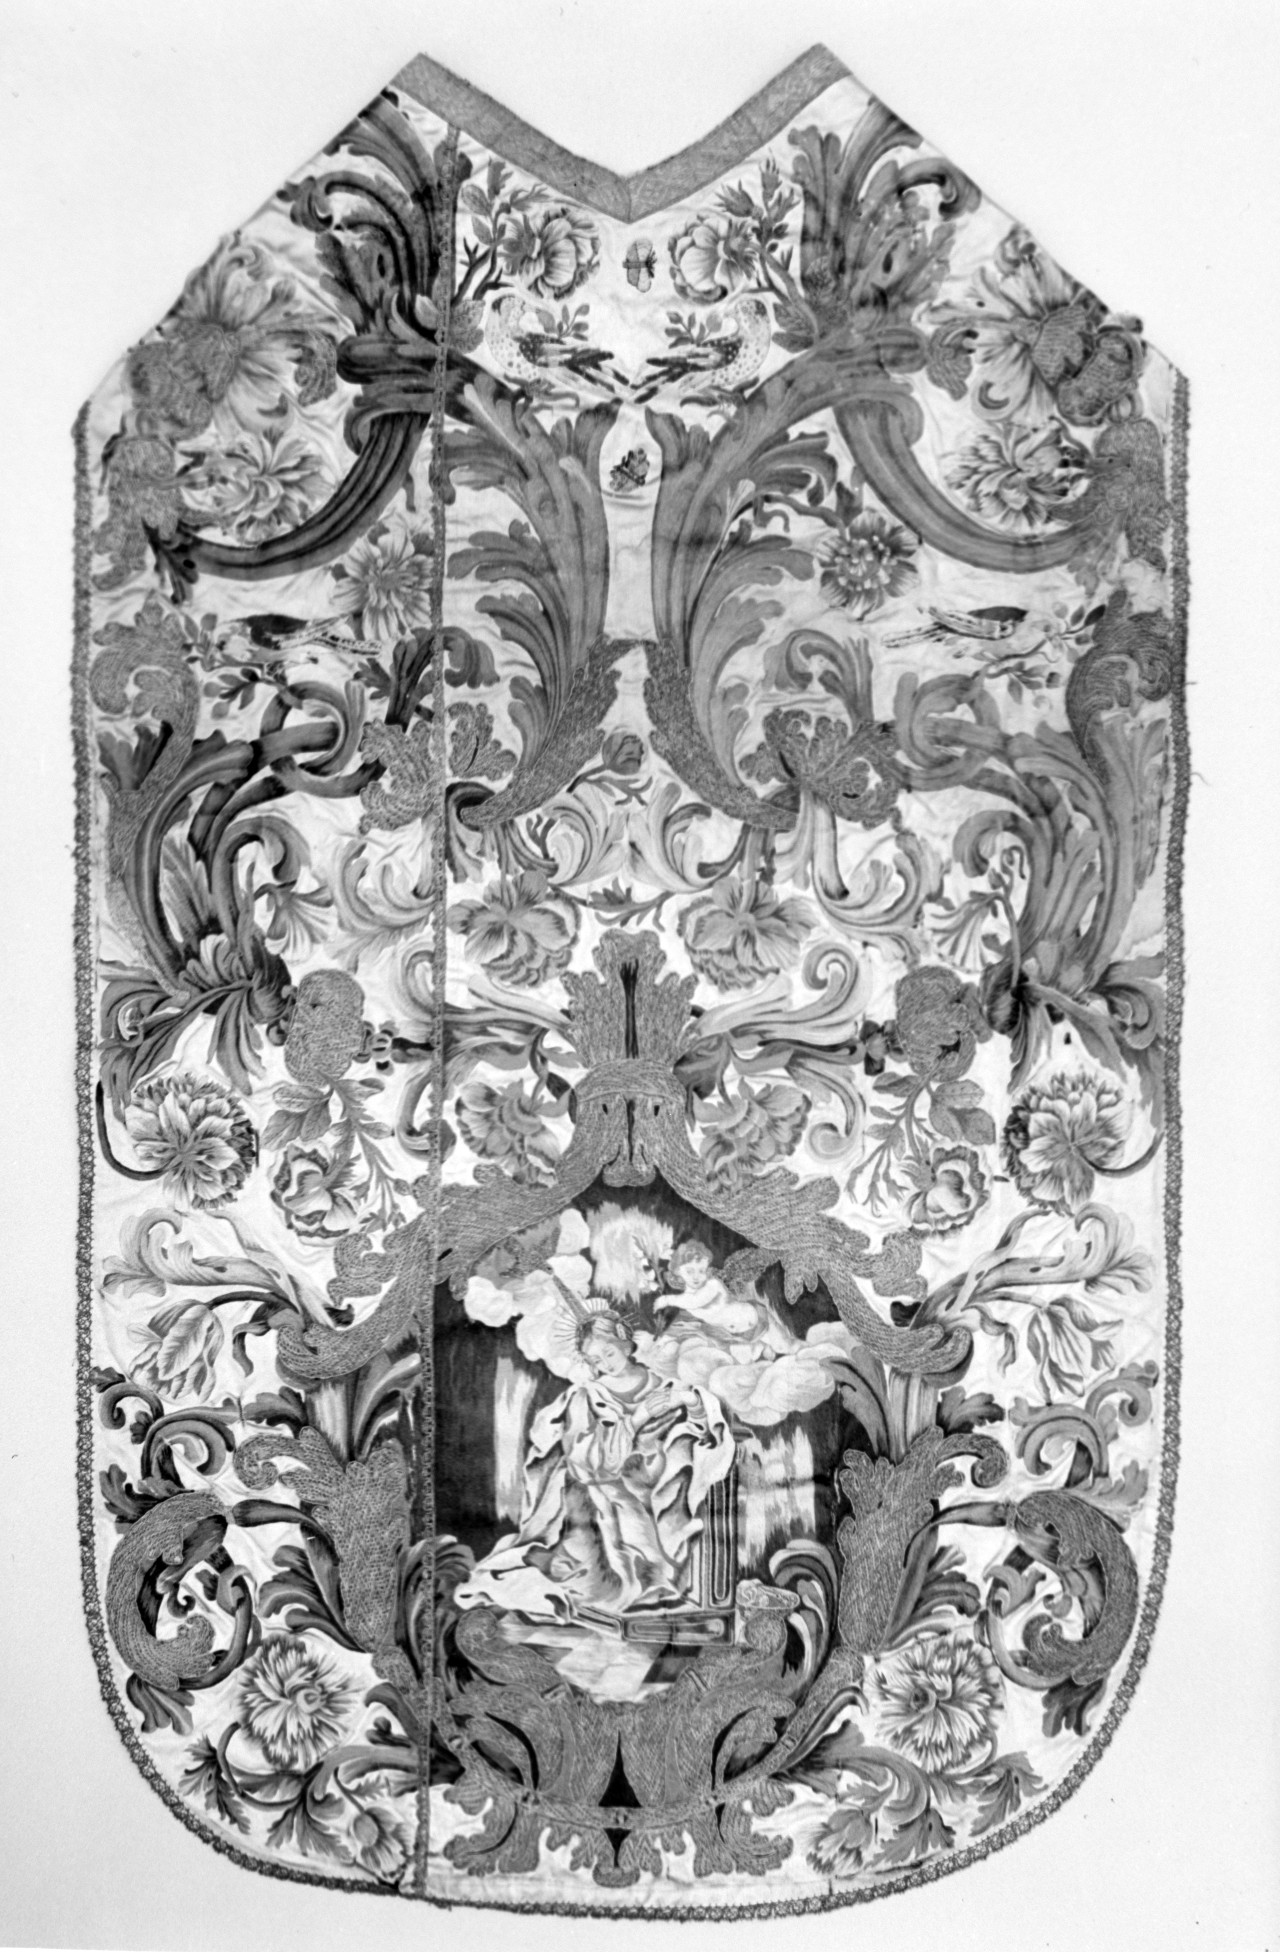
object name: chasuble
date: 1667-1700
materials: lace, metal, metal thread, silk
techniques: embroidery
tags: angels,virgin mary,annunciation